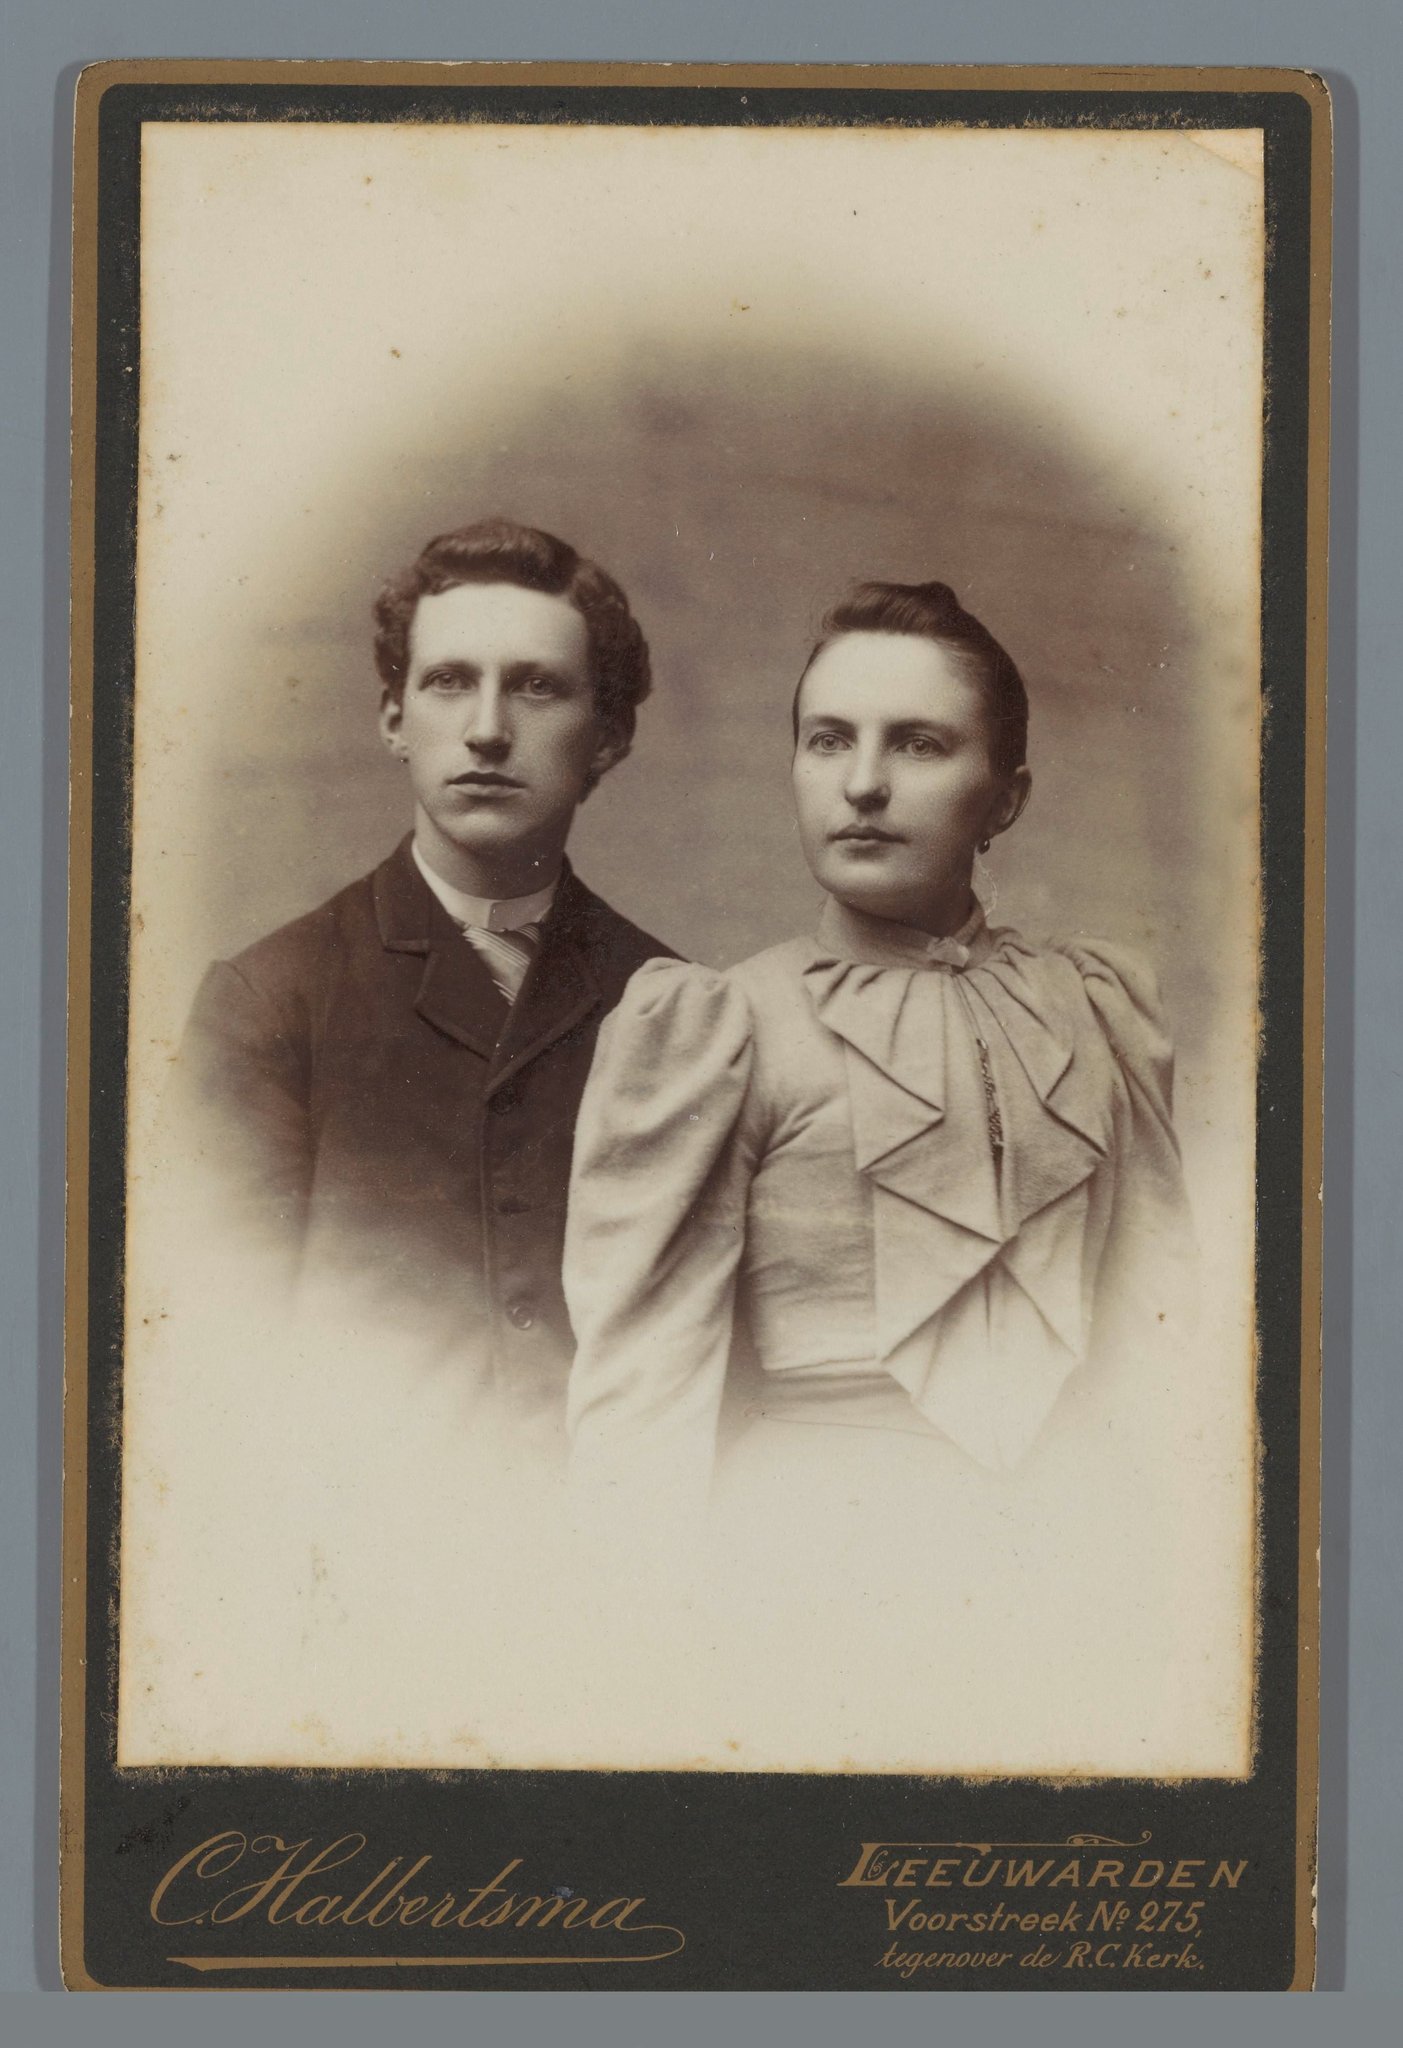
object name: cabinet photograph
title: Dubbelportret van J. de Roos en Neeltje Sinnema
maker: cornelis halbertsma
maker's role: fotograaf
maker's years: 1859-1935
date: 1891-1901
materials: cardboard, photographic support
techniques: gelatin silver print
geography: leeuwarden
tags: adult woman, adult man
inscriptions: name: ‘C. Halbertsma Voorstreek 275, tegenover de R.C. Kerk Leeuwarden. (...)’, name: ‘J. de Roos Neeltje Sinnema’